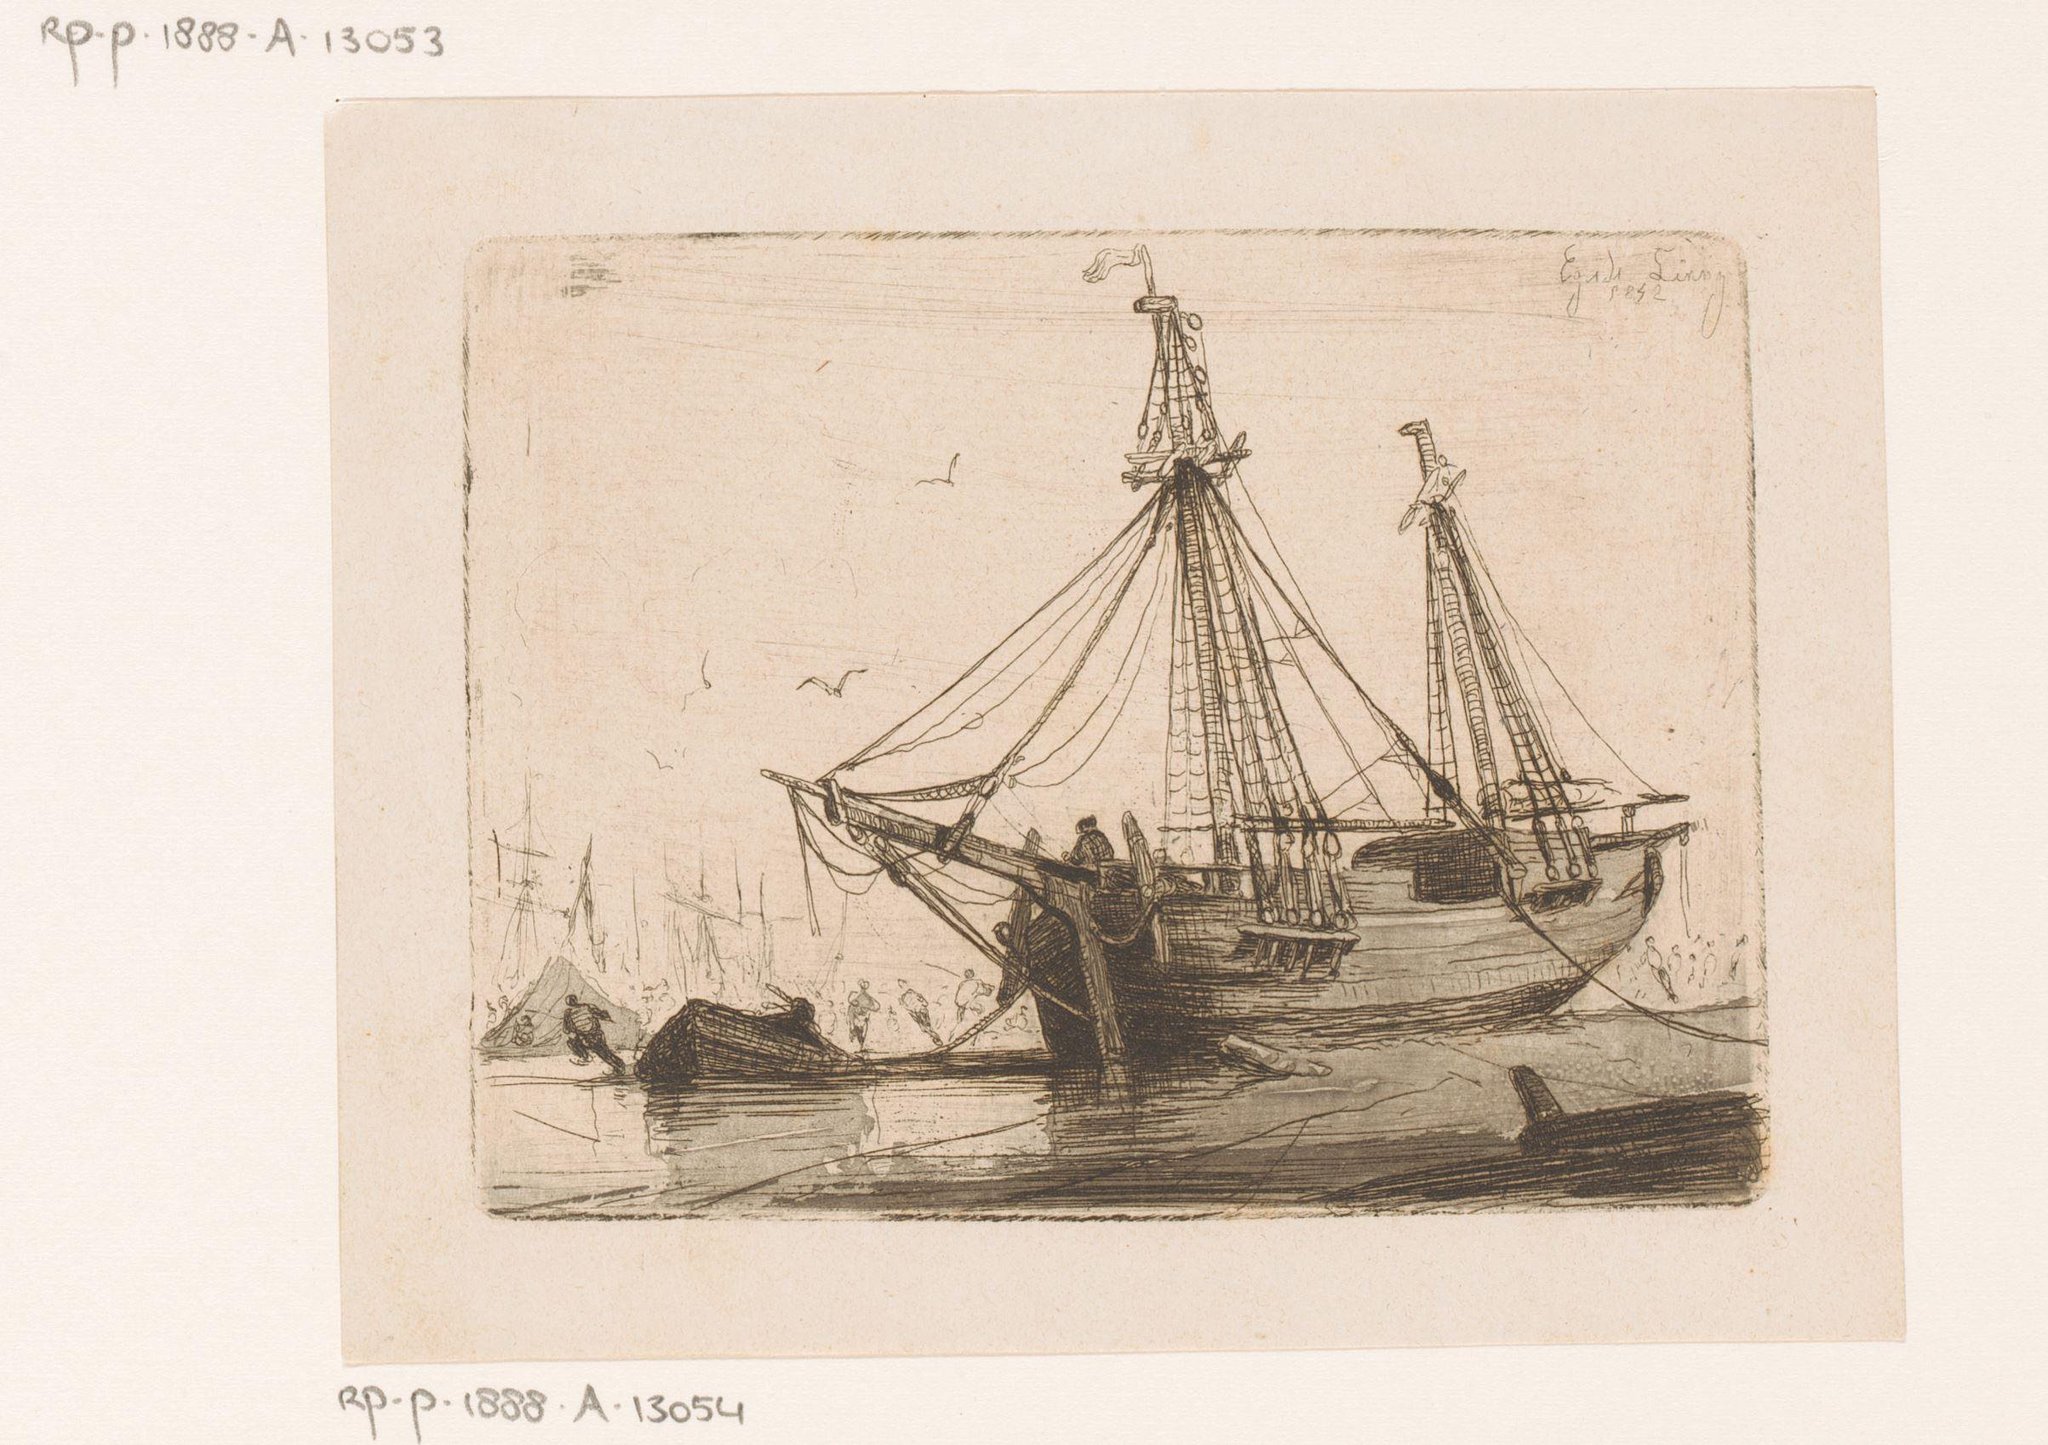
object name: print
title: Zeilschip in het winterdok in Antwerpen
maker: egidius linnig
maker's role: draughtsman, print maker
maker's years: 1821-1860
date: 1842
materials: paper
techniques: aquatint, etching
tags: sailing-ship, sailing-boat, ships, boats on land, beached, antwerp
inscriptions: collector's mark: Lugt 2228